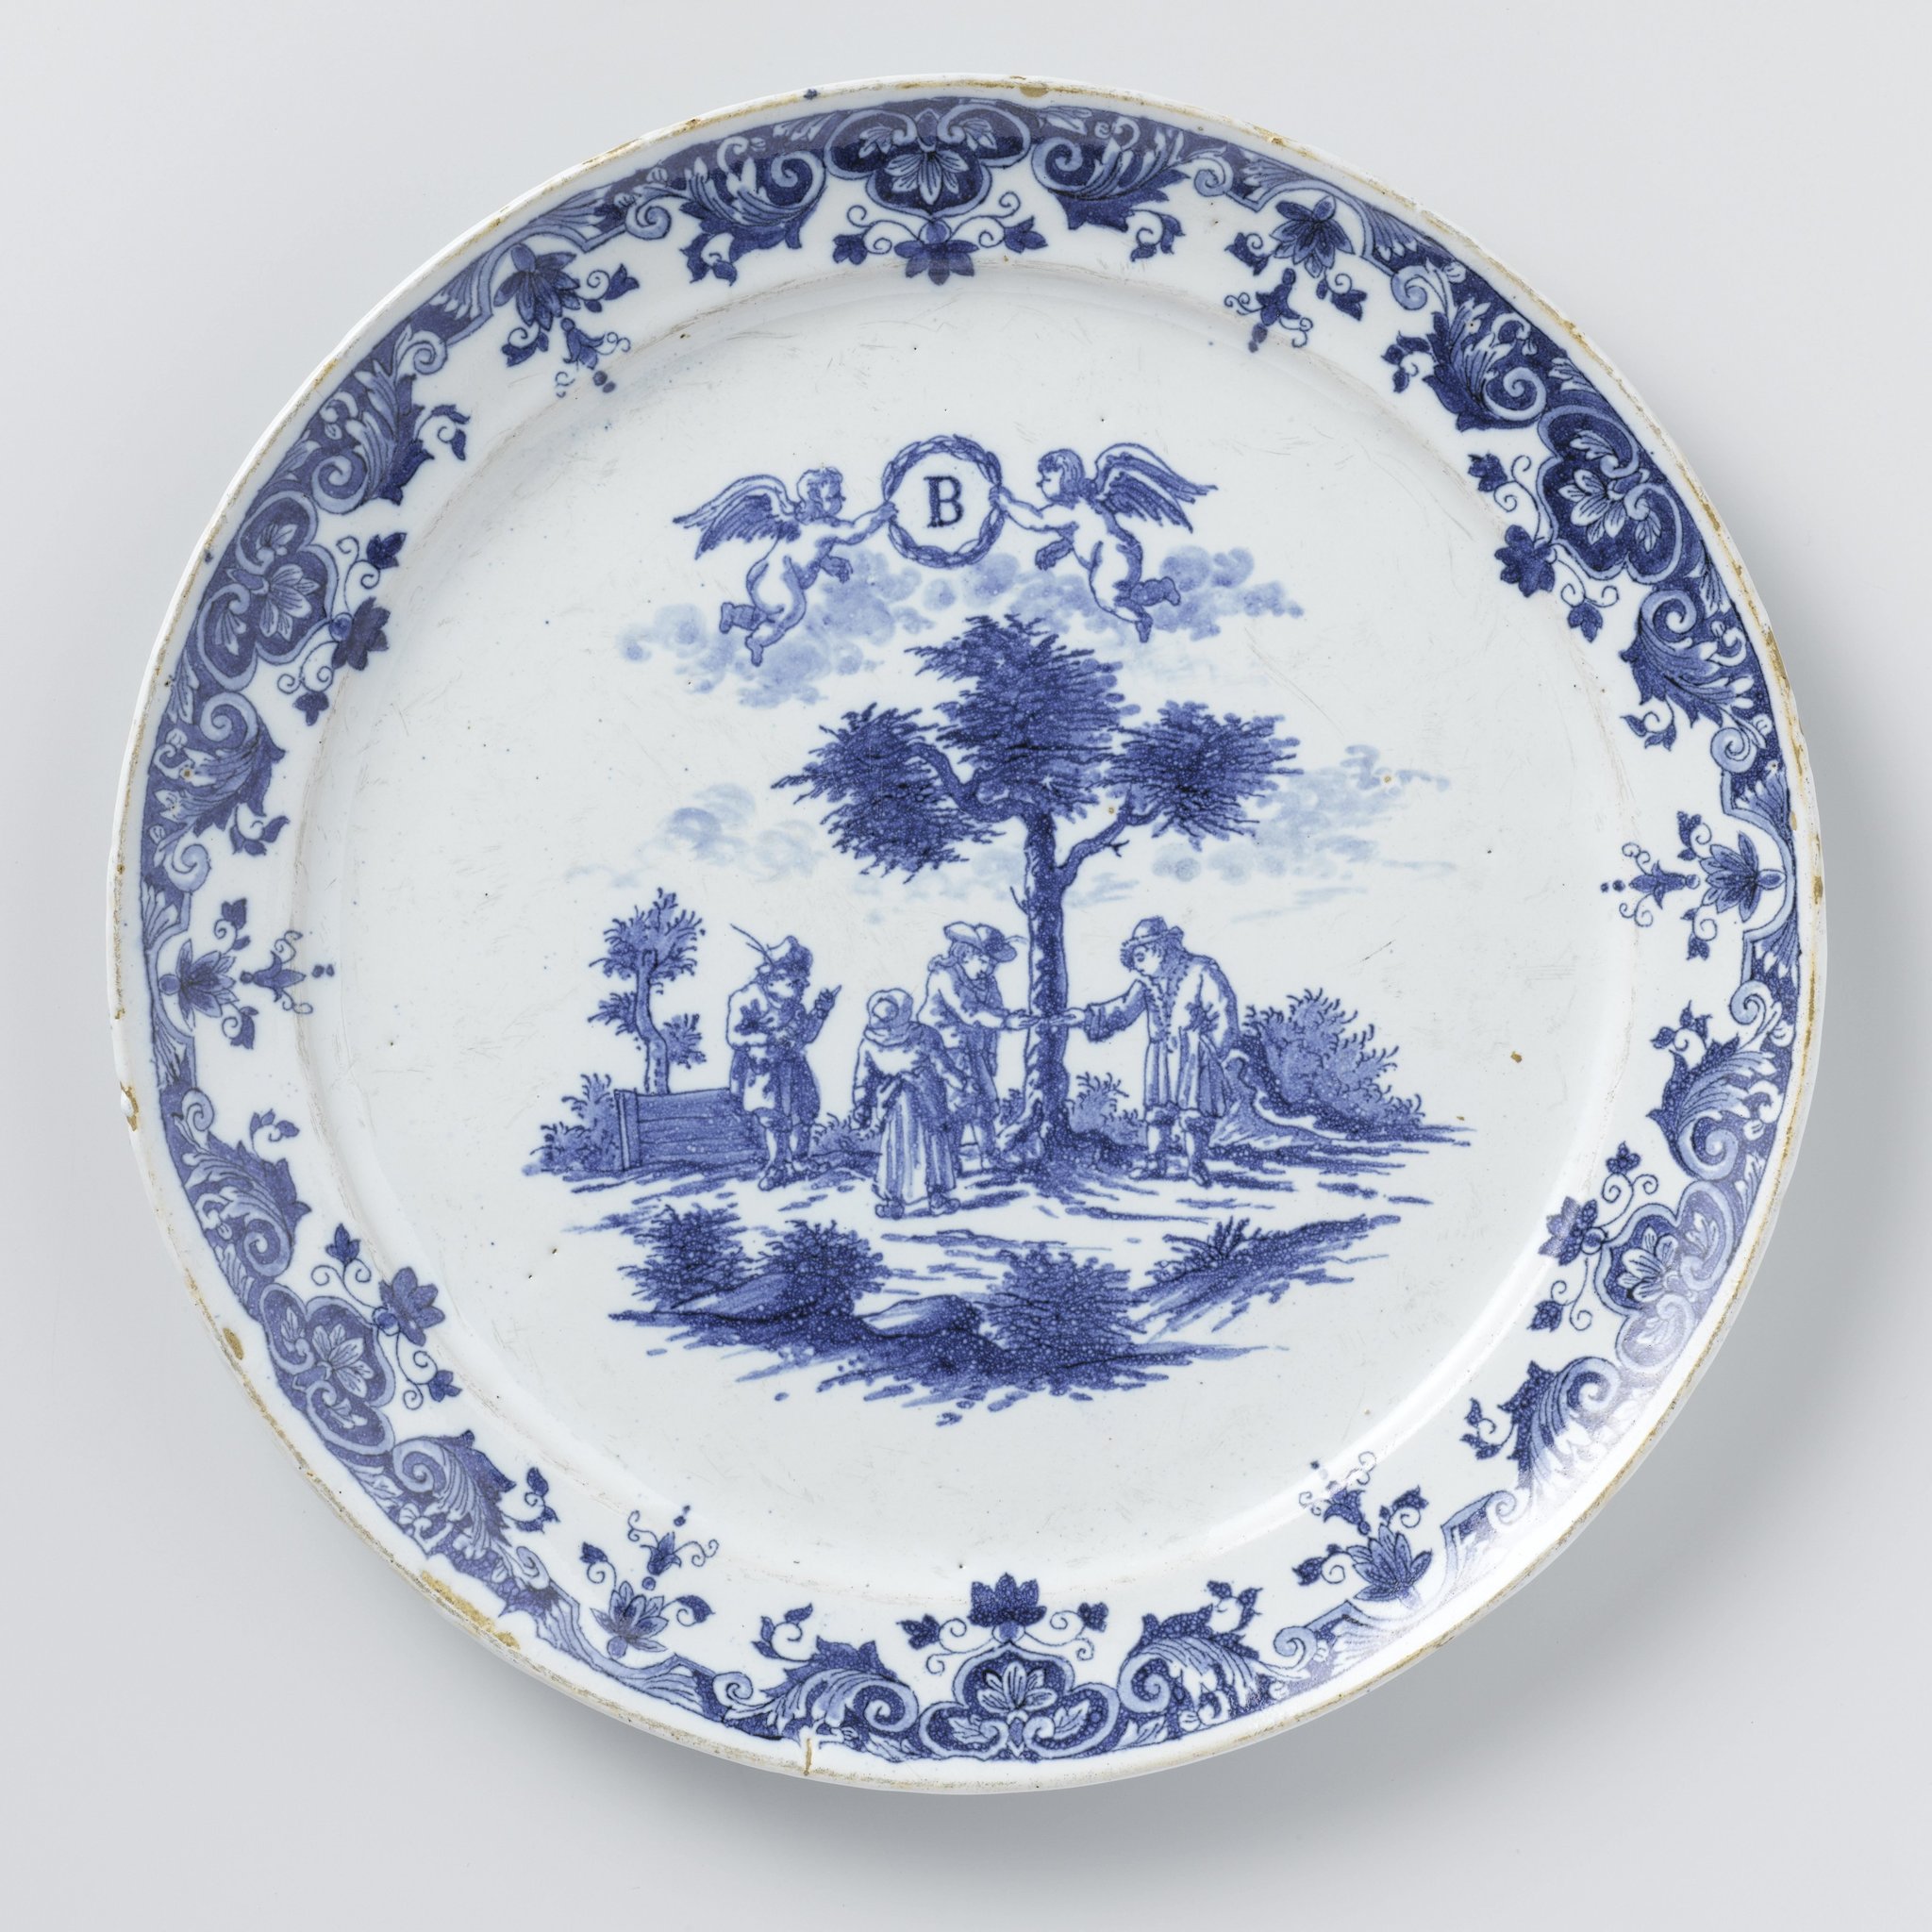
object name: forgery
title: Bord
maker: Anonymous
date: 1700-1725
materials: faience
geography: delft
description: Bord van faience. Blauw beschilderd met drie kinderen spelend bij een boom. Een vervalsing uit circa 1850-1880.